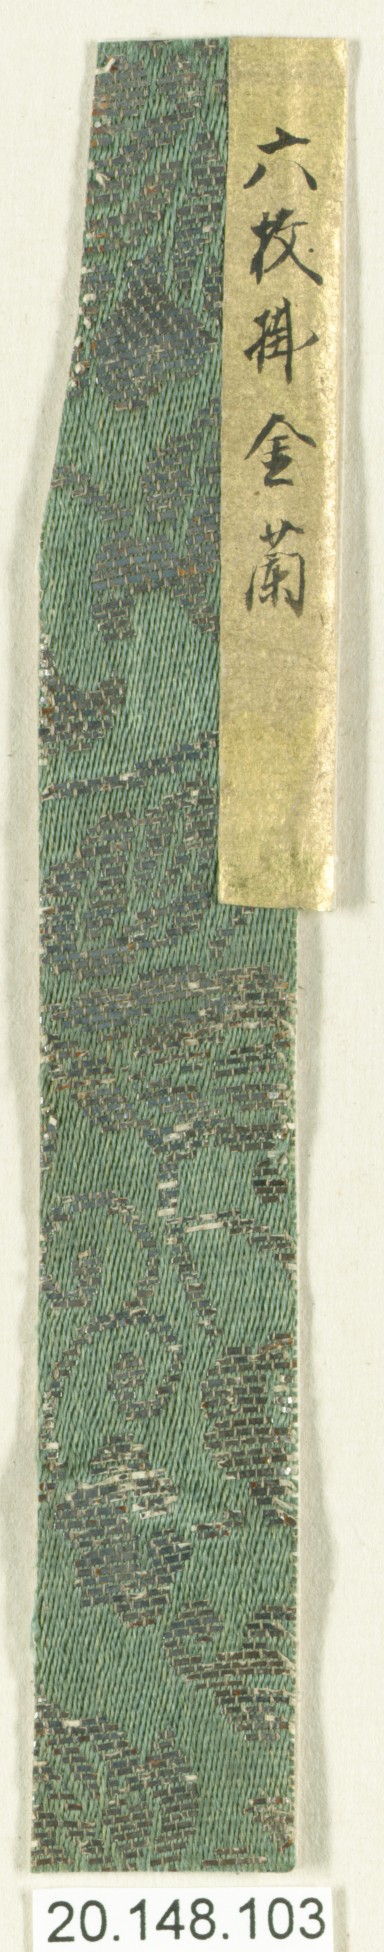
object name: piece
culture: japanese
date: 1601-1700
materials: silk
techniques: compound weave